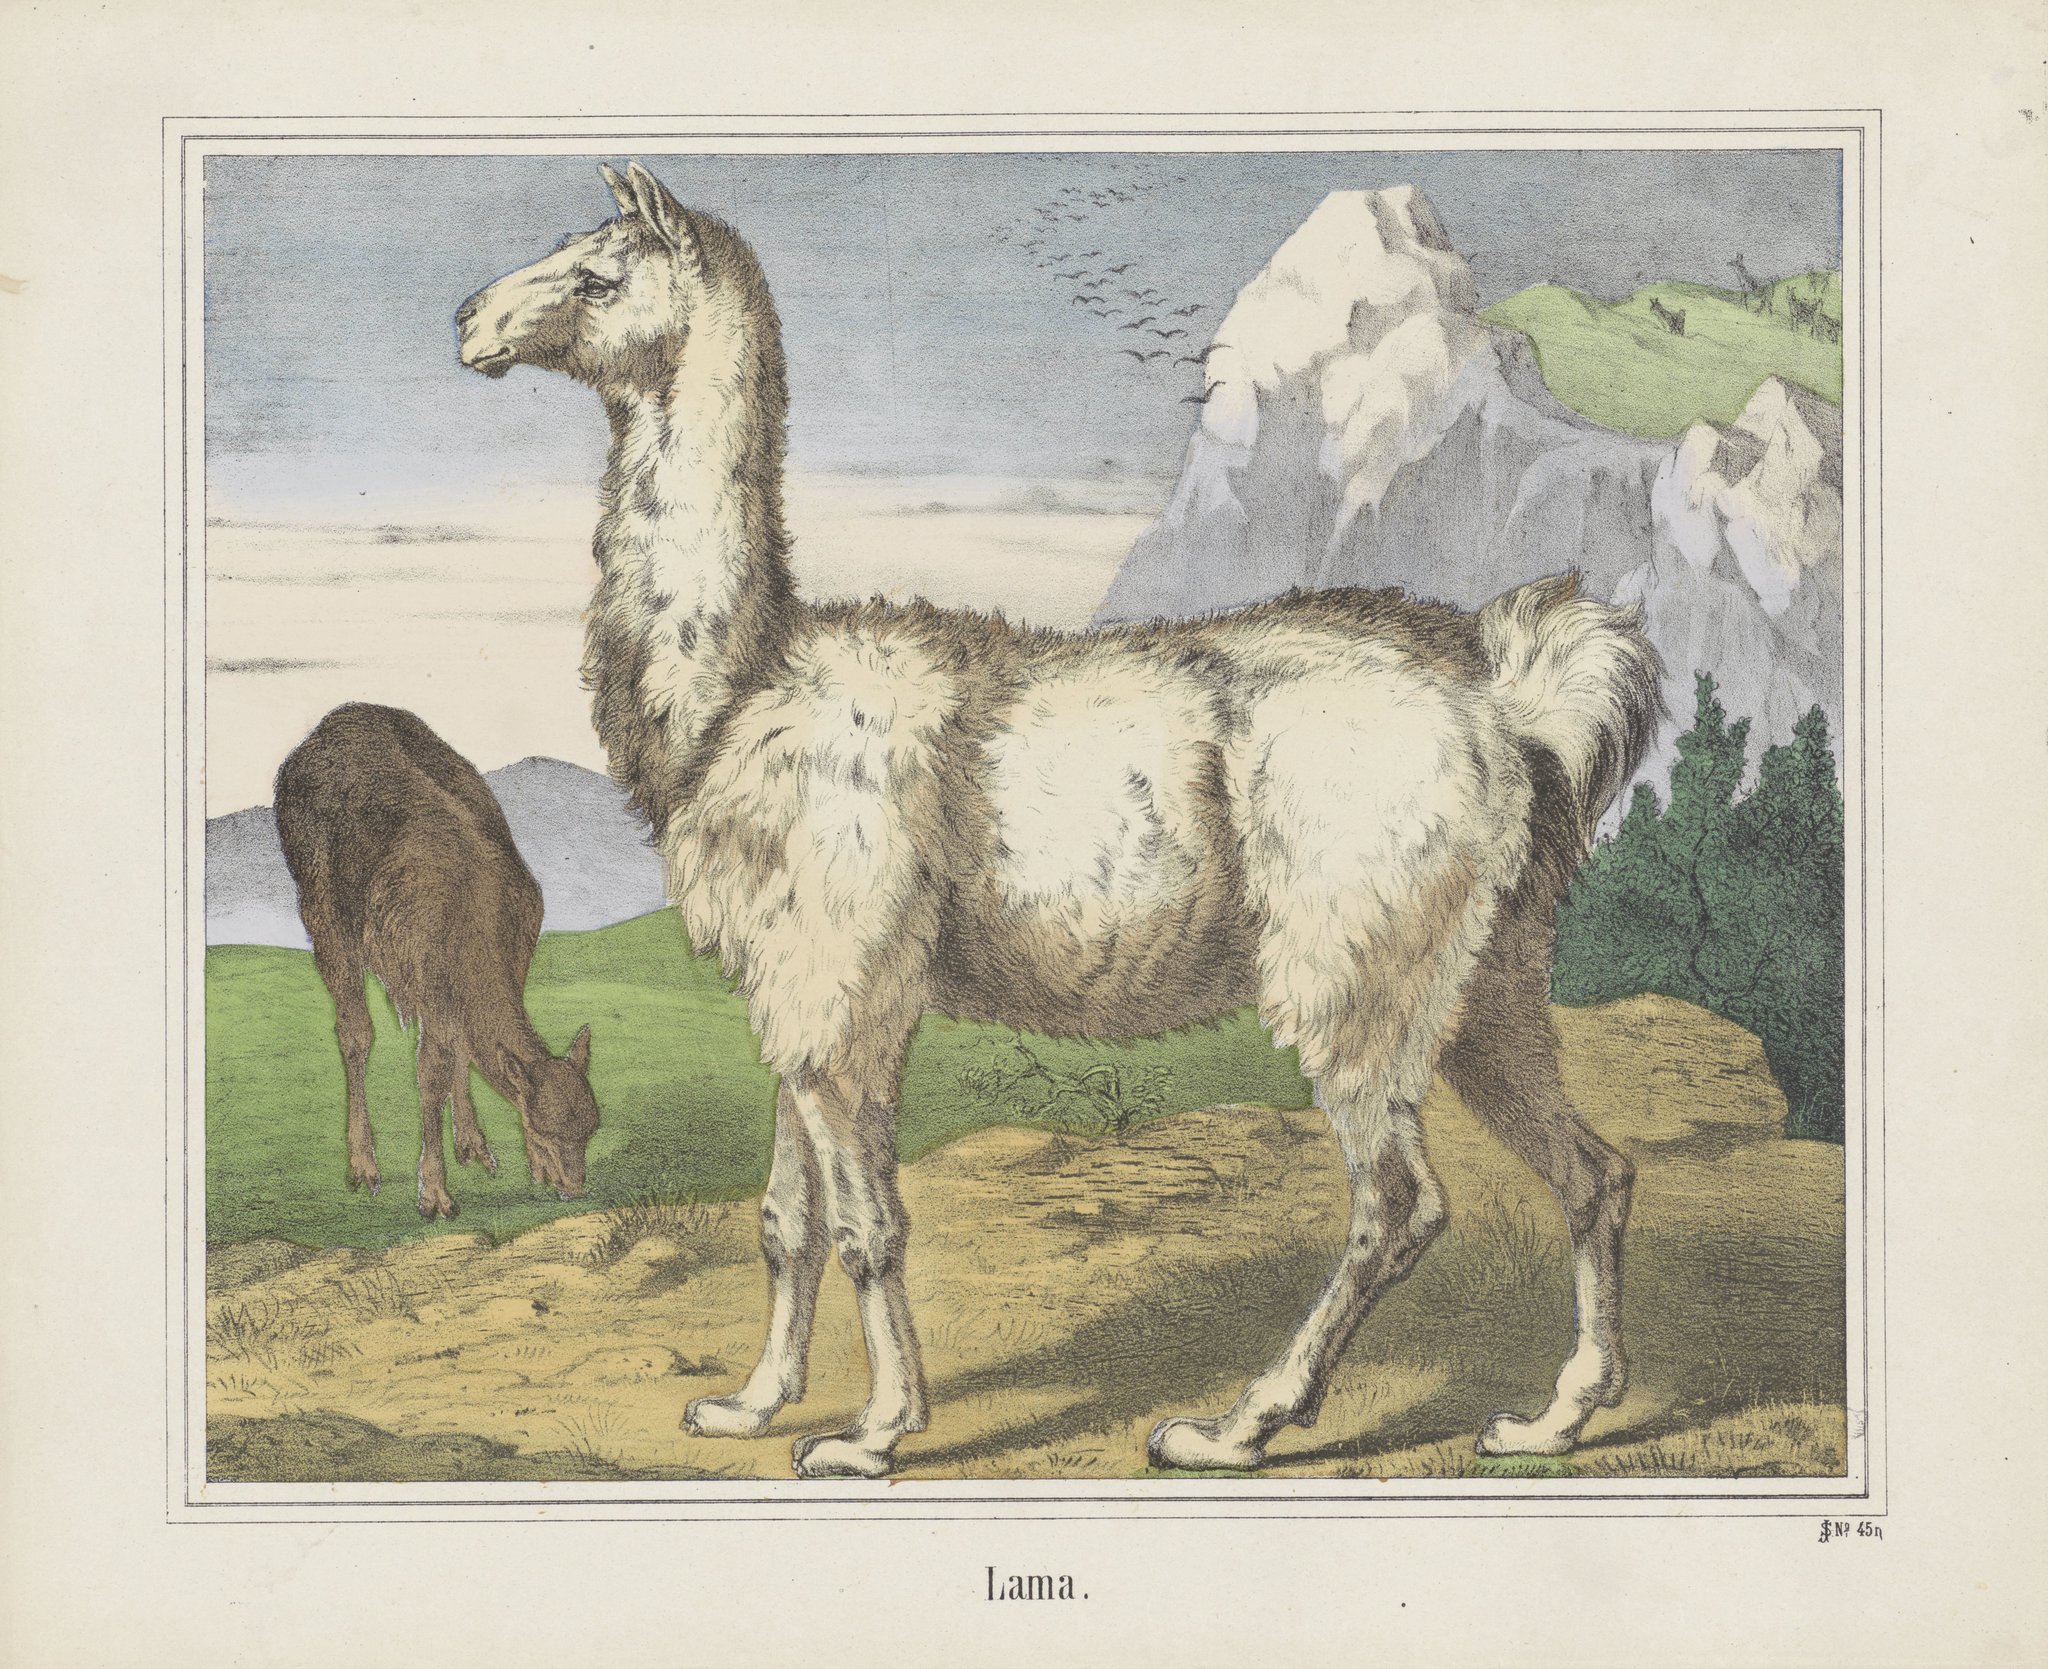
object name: popular print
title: Lama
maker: Anonymous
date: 1829-1880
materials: paper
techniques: colour, letterpress printing, lithograph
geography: mainz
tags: animals, hoofed animals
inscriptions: collector's mark: Lugt 2760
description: Twee lama's in een berglandschap. Genummerd rechtsonder: No. 45n.